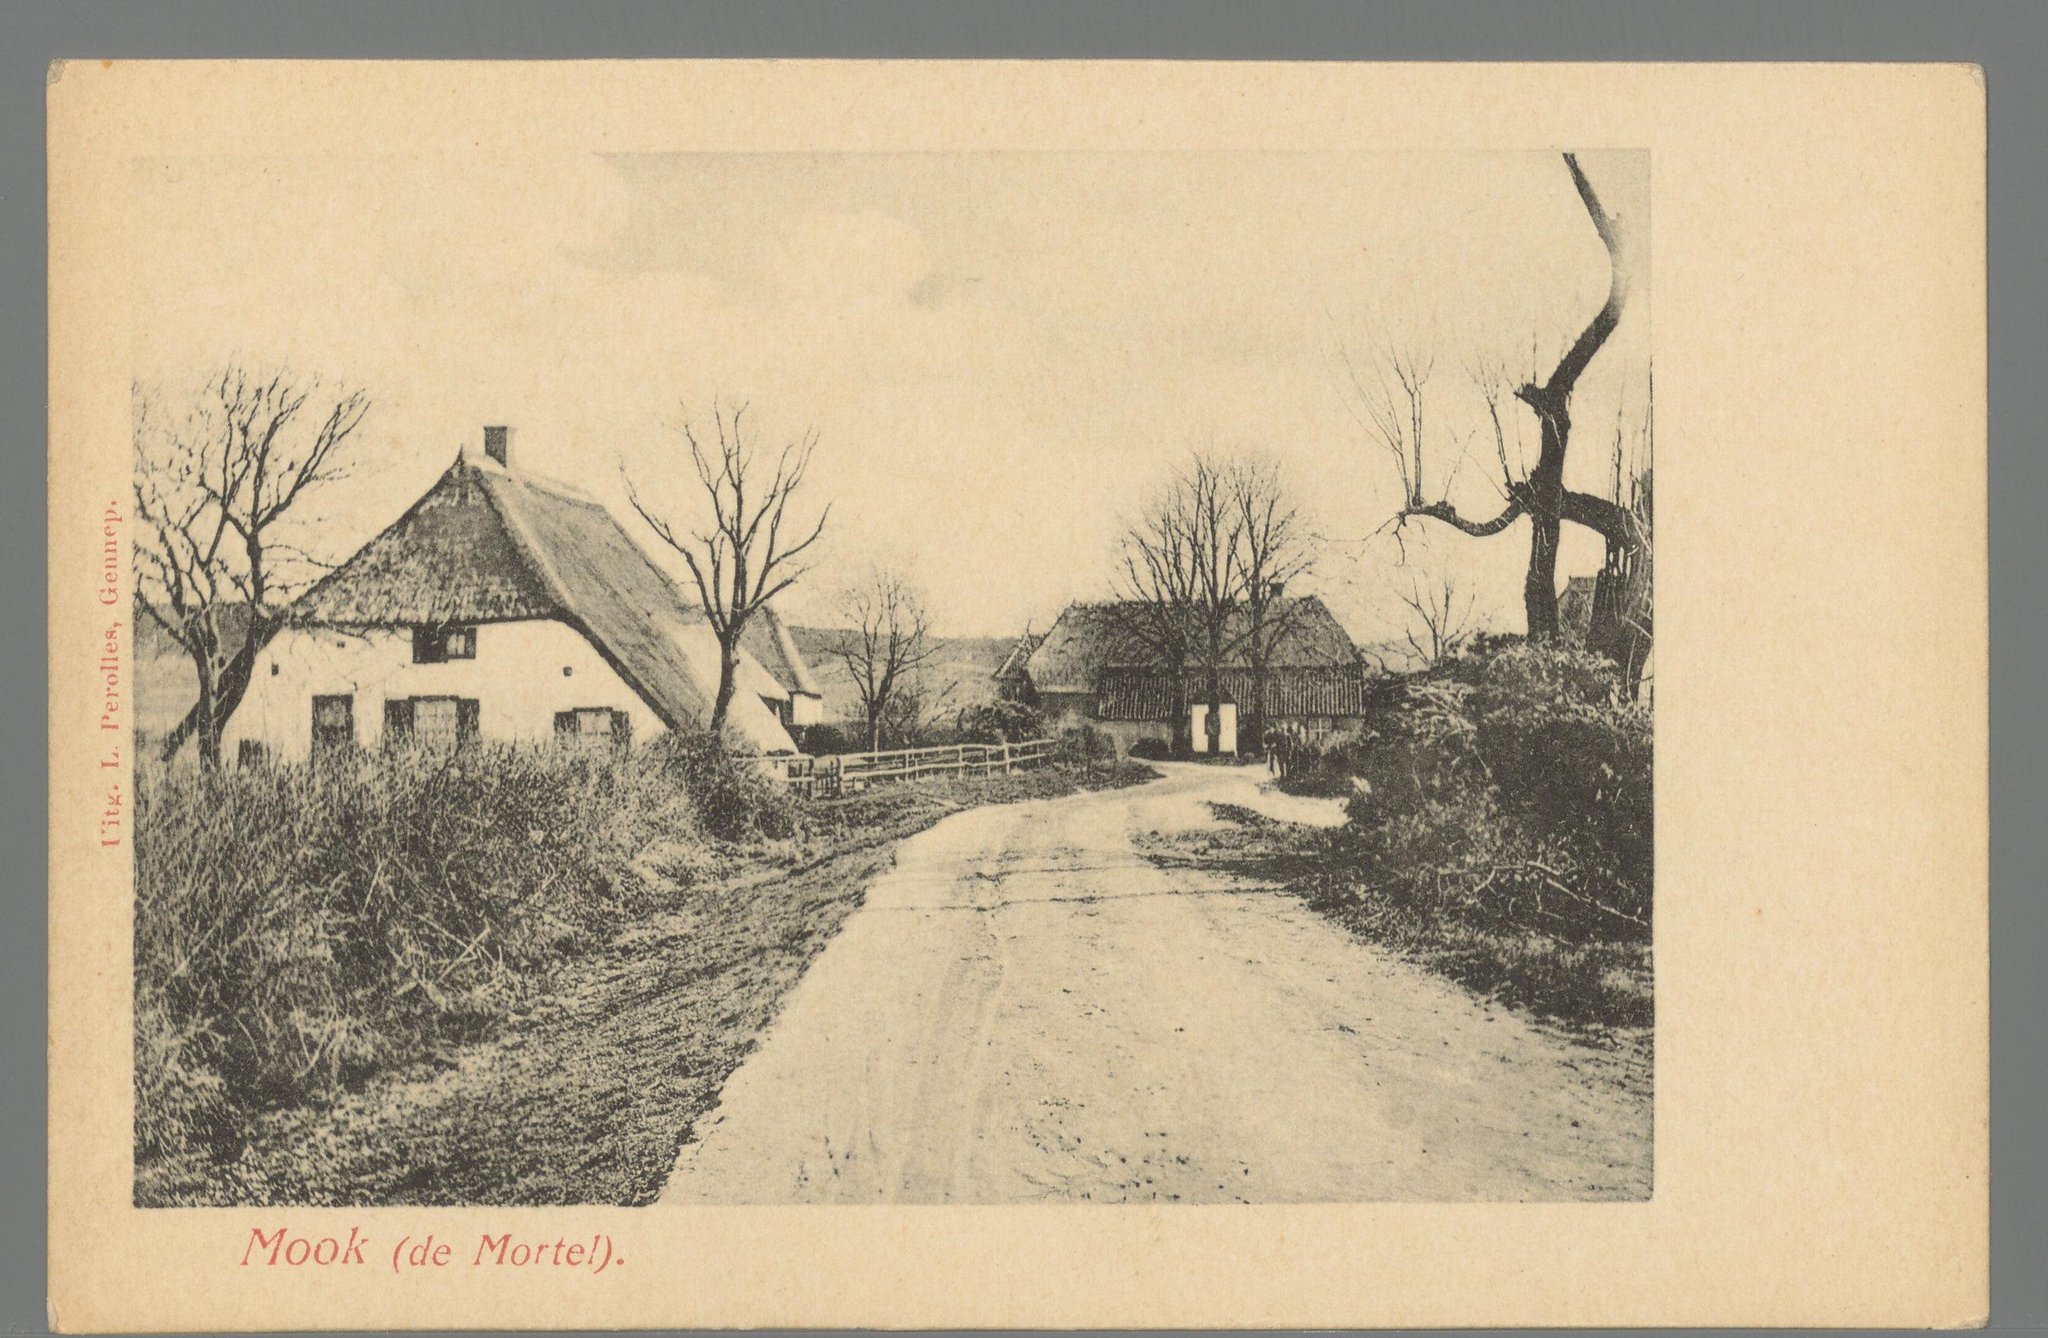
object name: ansichtkaart, prentbriefkaart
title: Mook (de Mortel)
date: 1892-1905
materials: cardboard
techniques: photograph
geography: mook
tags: rural housing, e.g. country-house, villa, cottage